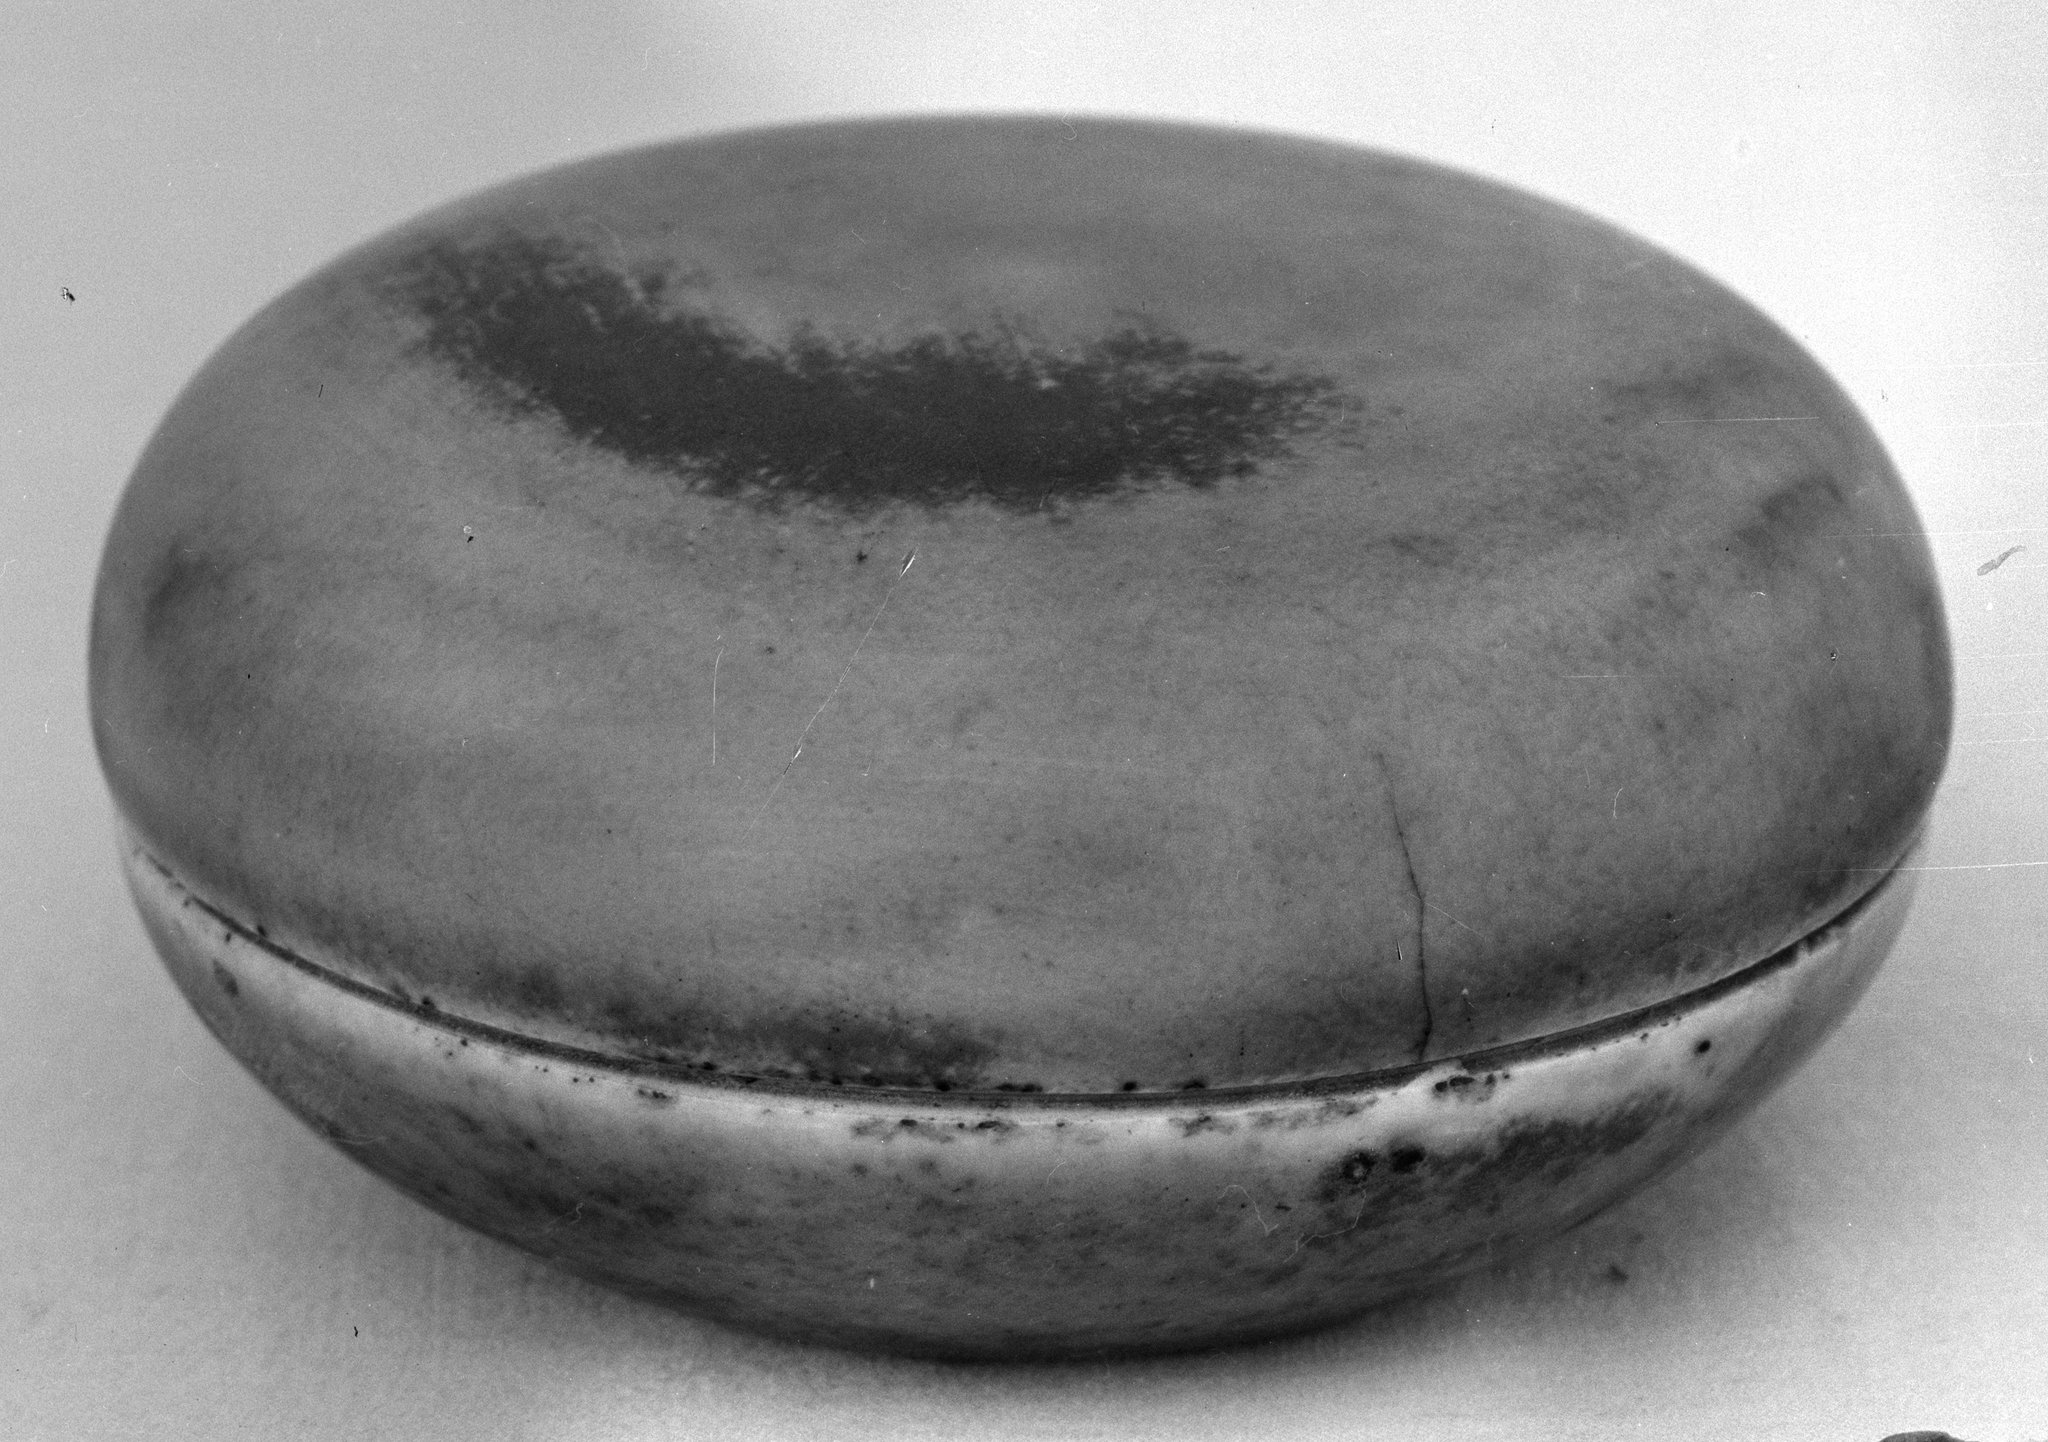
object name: seal paste box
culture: chinese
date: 1667-1733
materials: glaze, porcelain